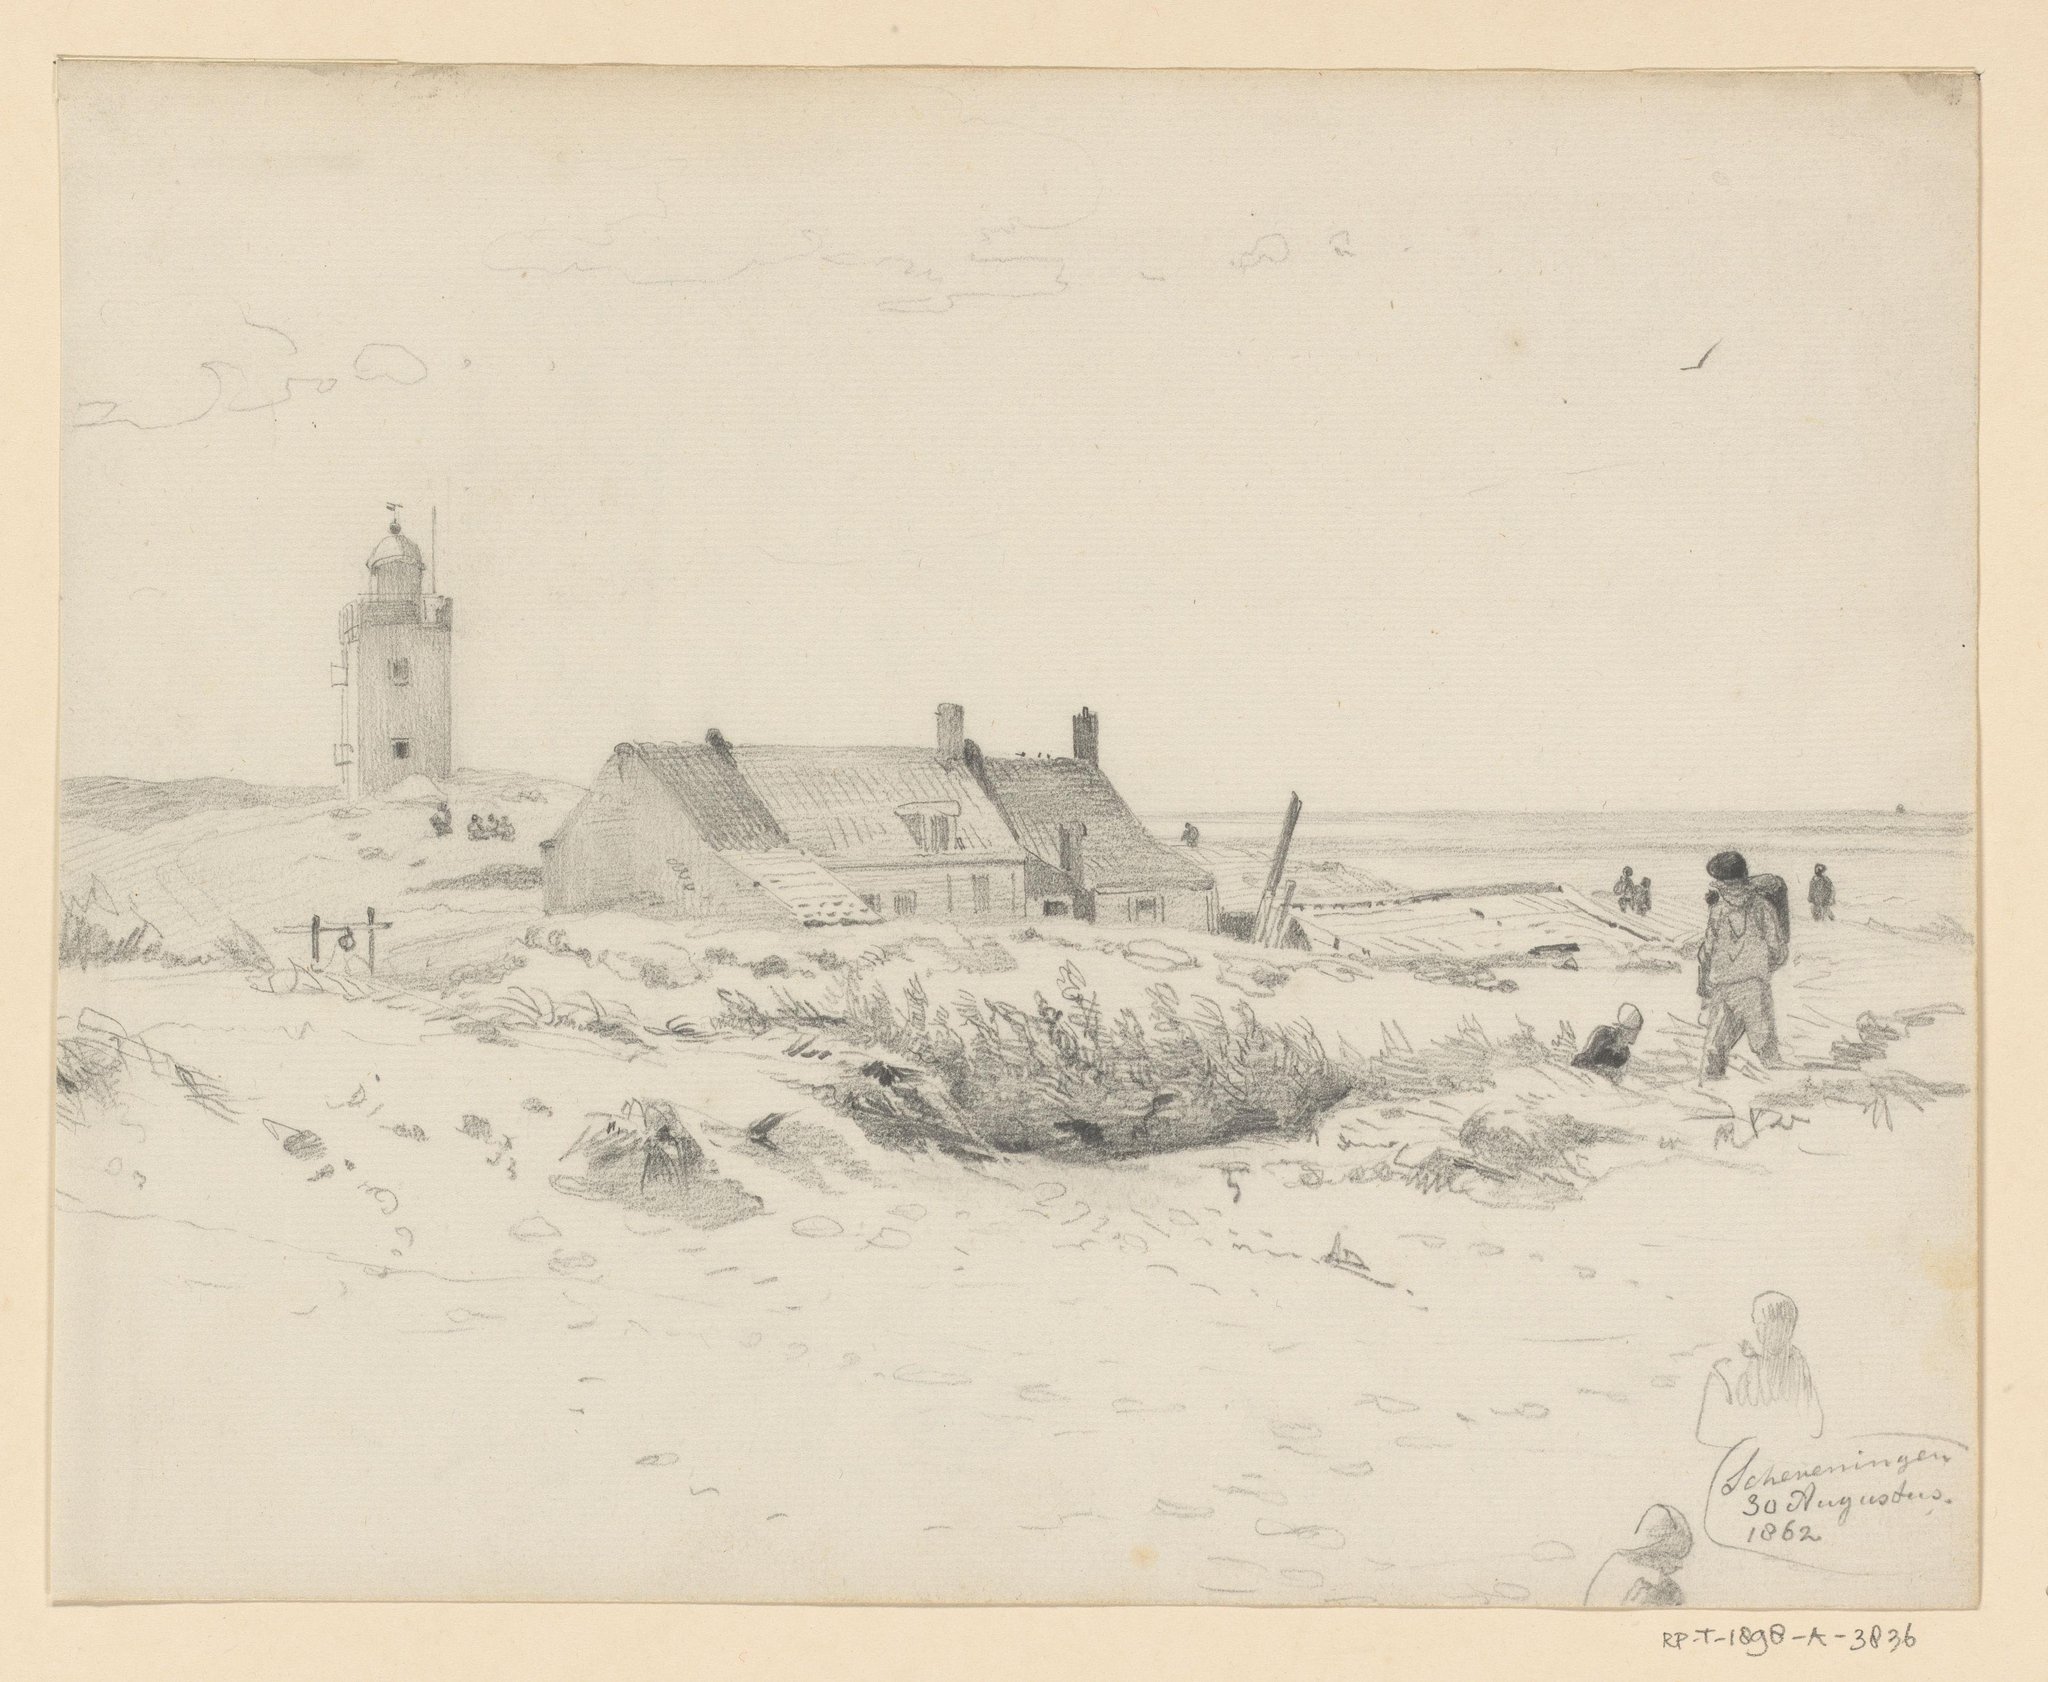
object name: drawing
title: Vuurtoren en huis aan de kust bij Scheveningen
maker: willem anthonie van deventer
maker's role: draughtsman, painter, print maker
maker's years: 1824-1893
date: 1862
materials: paper, pencil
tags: lighthouse, lightship, beach